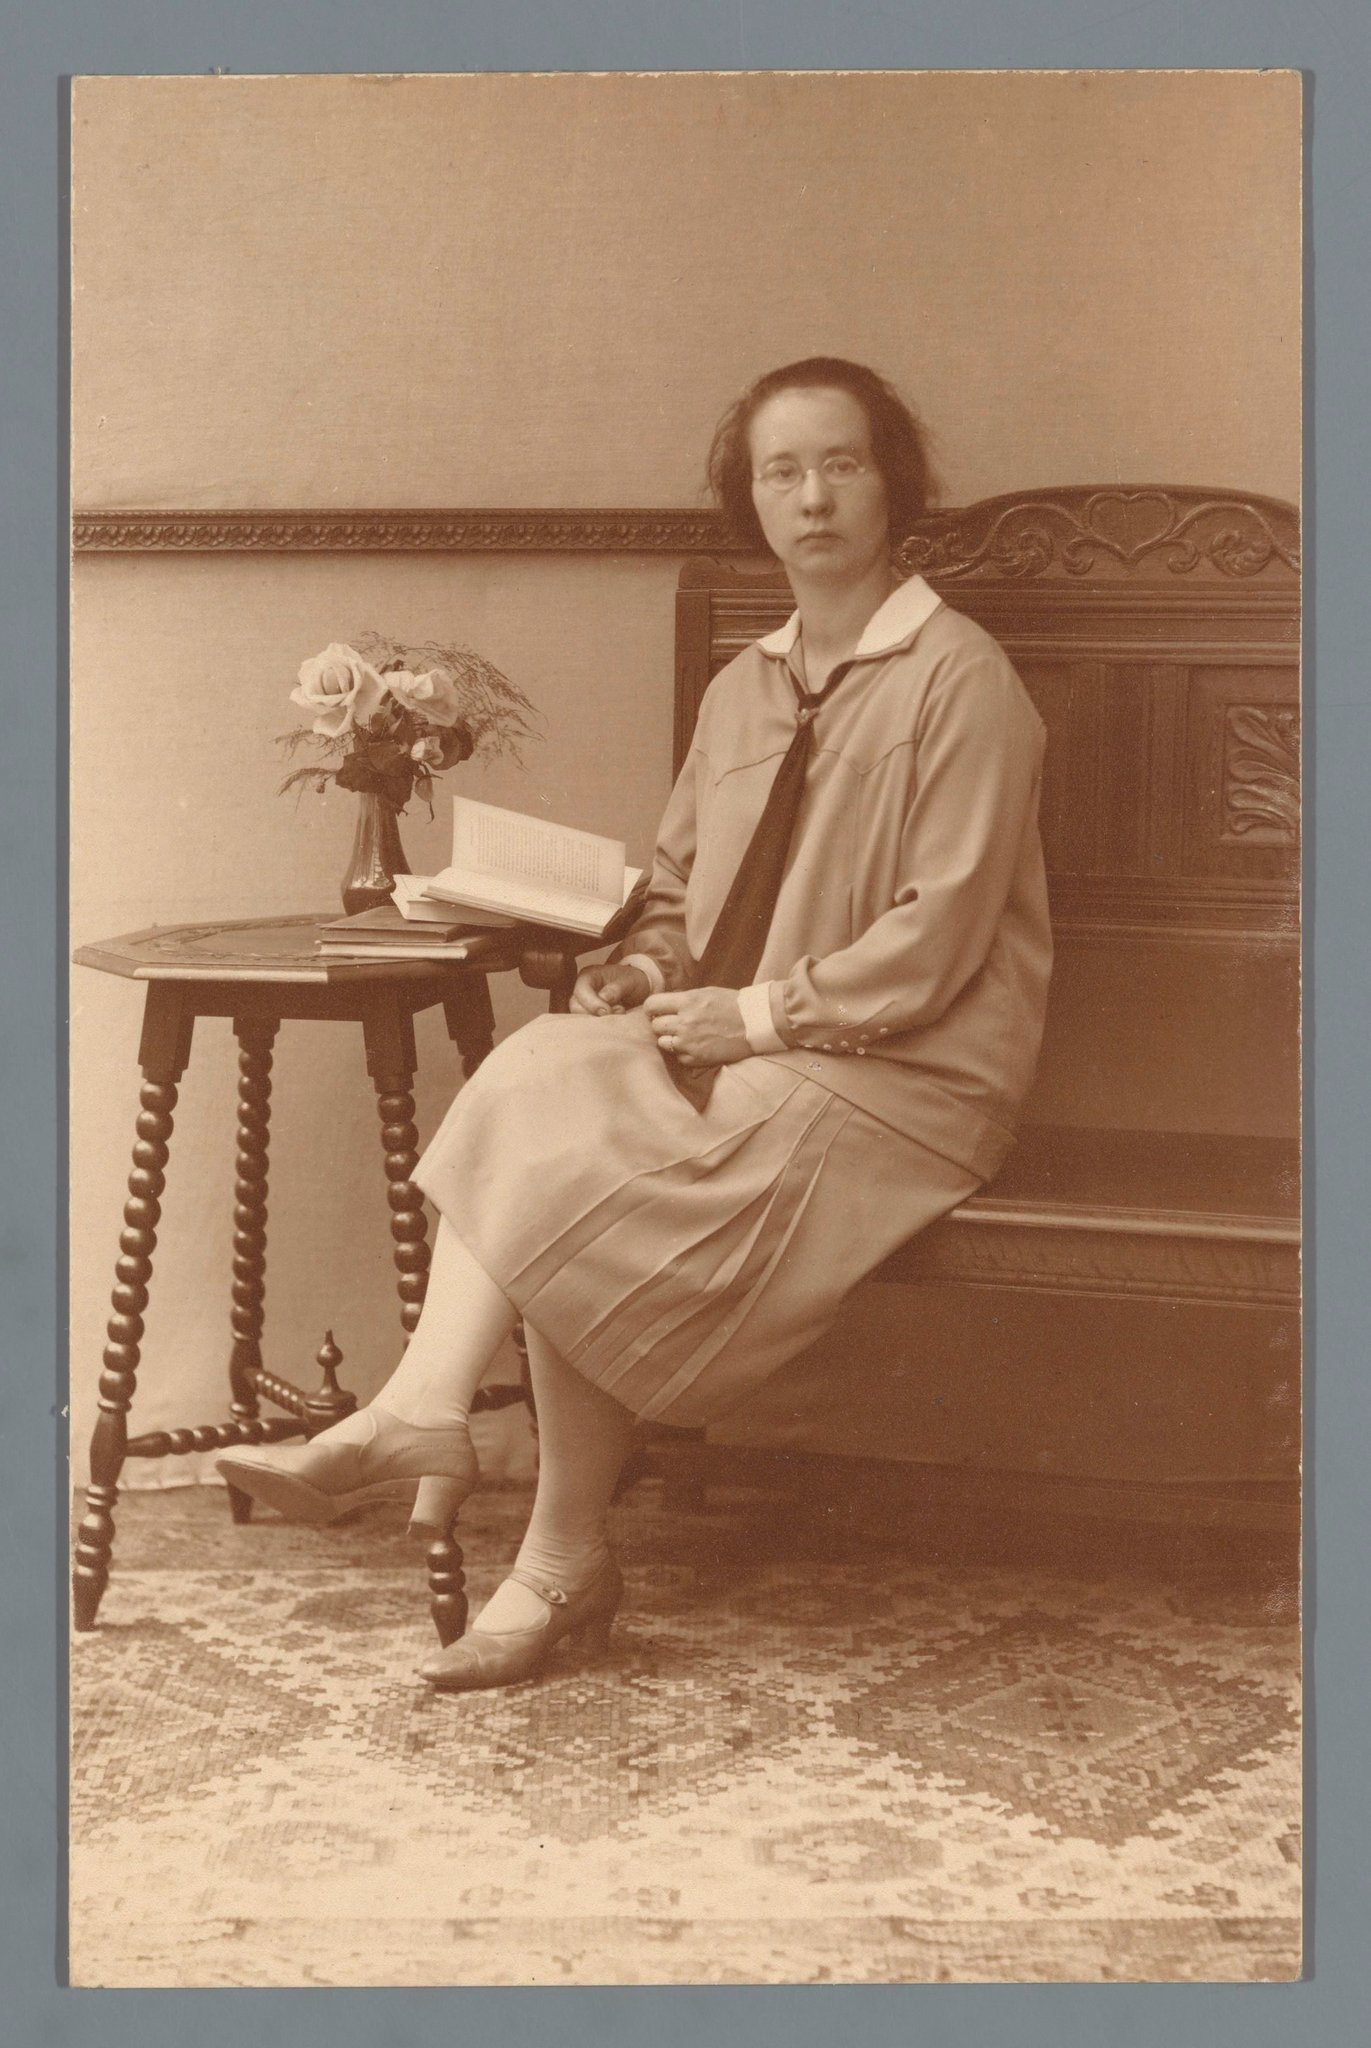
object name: photograph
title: Portret van een onbekende vrouw op een bank in een interieur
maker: Anonymous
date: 1920-1940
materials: photographic support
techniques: gelatin silver print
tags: bench, historical persons not known by name - bb - woman, interior ~ representation of a building